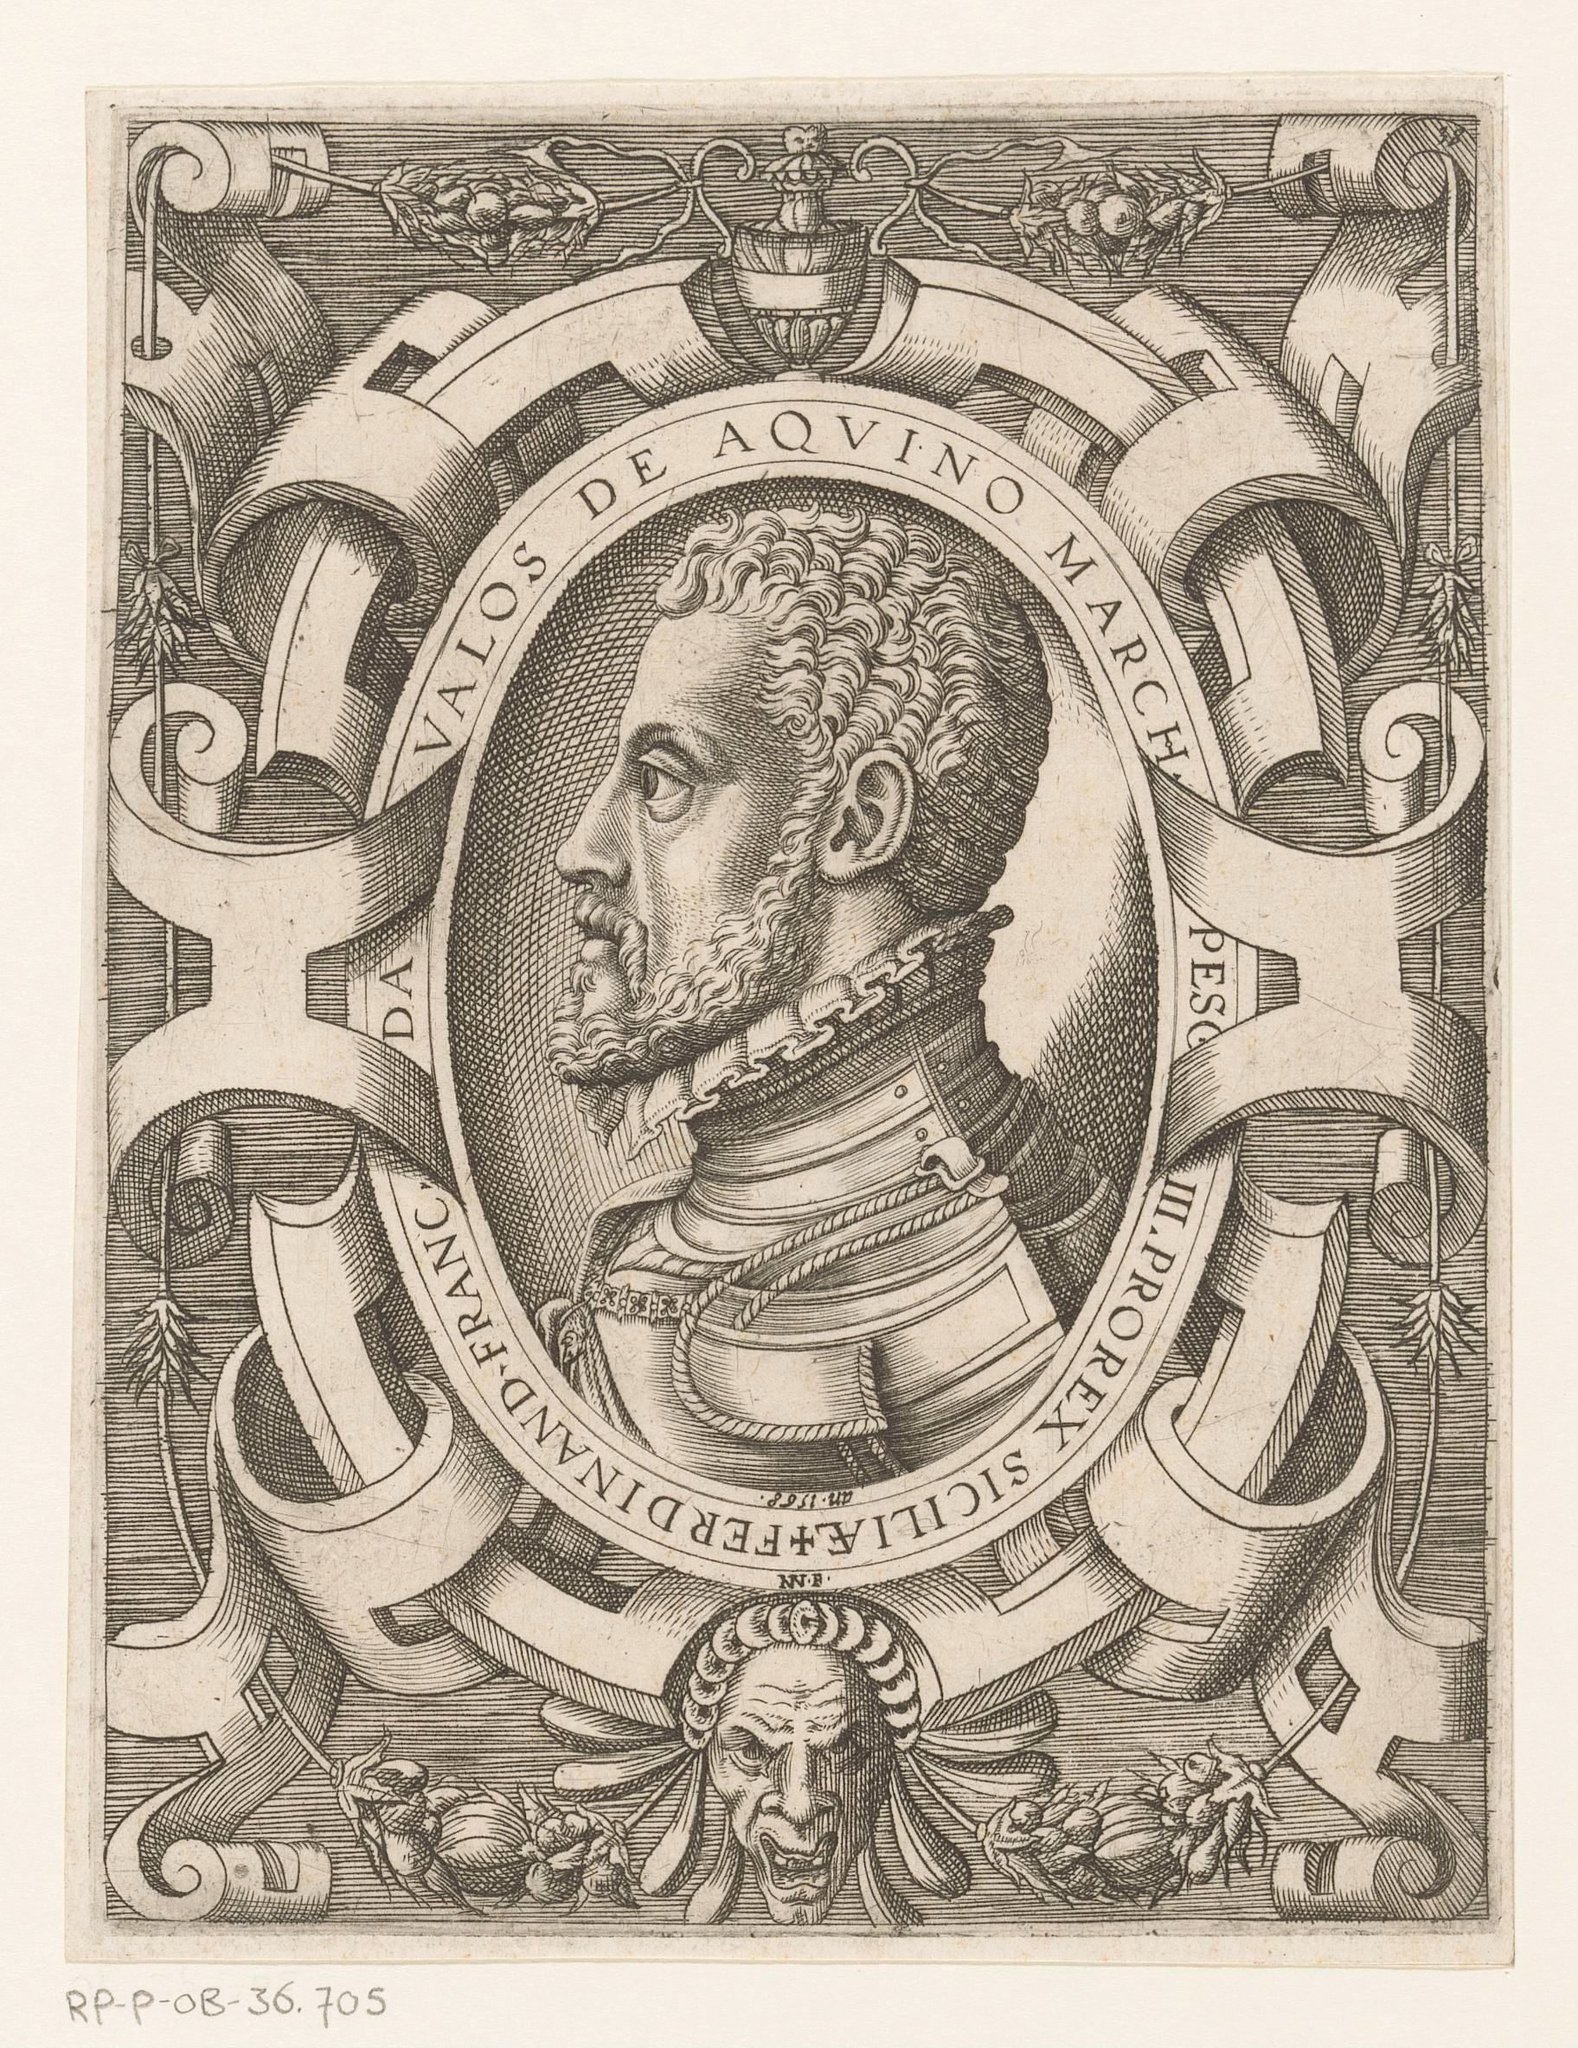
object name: print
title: Portretten van vorsten en andere illustere figuren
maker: niccolò nelli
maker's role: print maker, publisher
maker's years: 1535-1585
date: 1568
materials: paper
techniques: engraving, etching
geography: venice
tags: fruits and vegetables ~ ornament, historical persons, knighthood order of the golden fleece - insignia of a knighthood order, e.g.: badge, chain (with name of order), ornament derived from architectural details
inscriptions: collector's mark: Lugt 2228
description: Prent mogelijk gebruikt voor een serie portretten van onbekende omvang getiteld 'Imagines Quorundam Principum et Illustrium Virorum' met prenten door Niccolò Nelli, Domenico Zenoi, Martino Rota, Nicolas Bèatrizet en Cornelis Cort, uitgegeven in 1569 te Venetië.